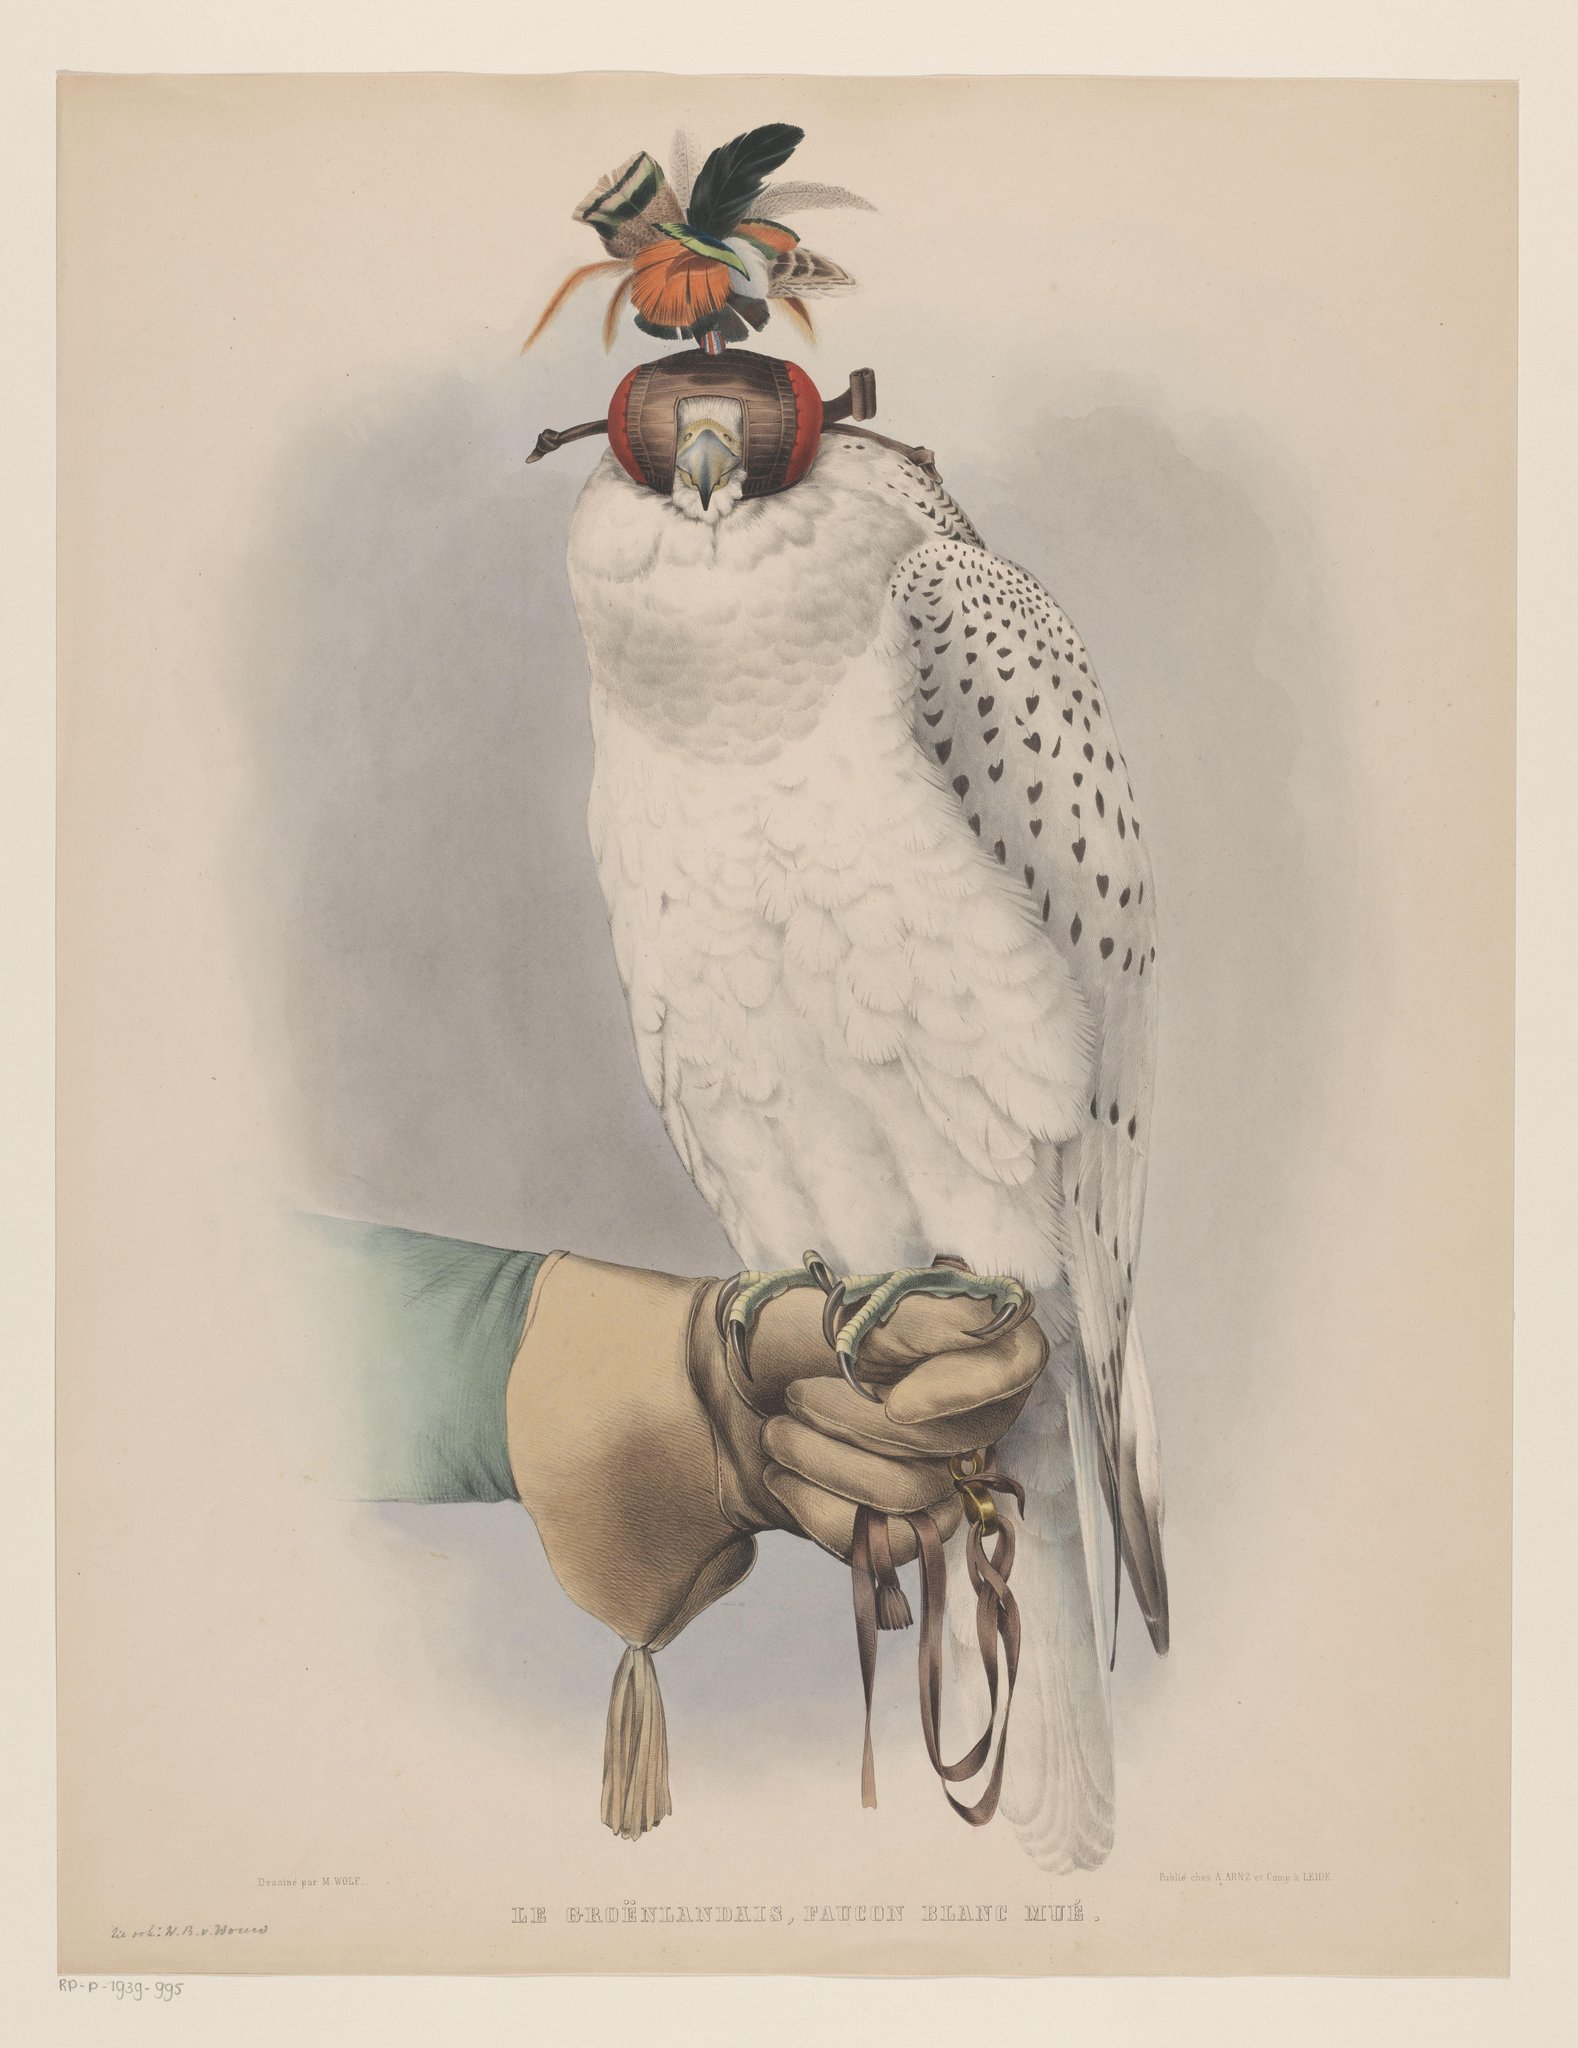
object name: book illustration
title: Witte Groenlandse valk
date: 1844-1853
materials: paper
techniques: lithograph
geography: leiden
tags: predatory birds: falcon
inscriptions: collector's mark: Lugt 2228, collector's mark: Lugt 2760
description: Prent uit: Schlegel, Hermann; Verster van Wulverhorst, Abraham H. Traité de fauconnerie. Leiden en Düsseldorf: Arnz & Co., August, 1844-1853.